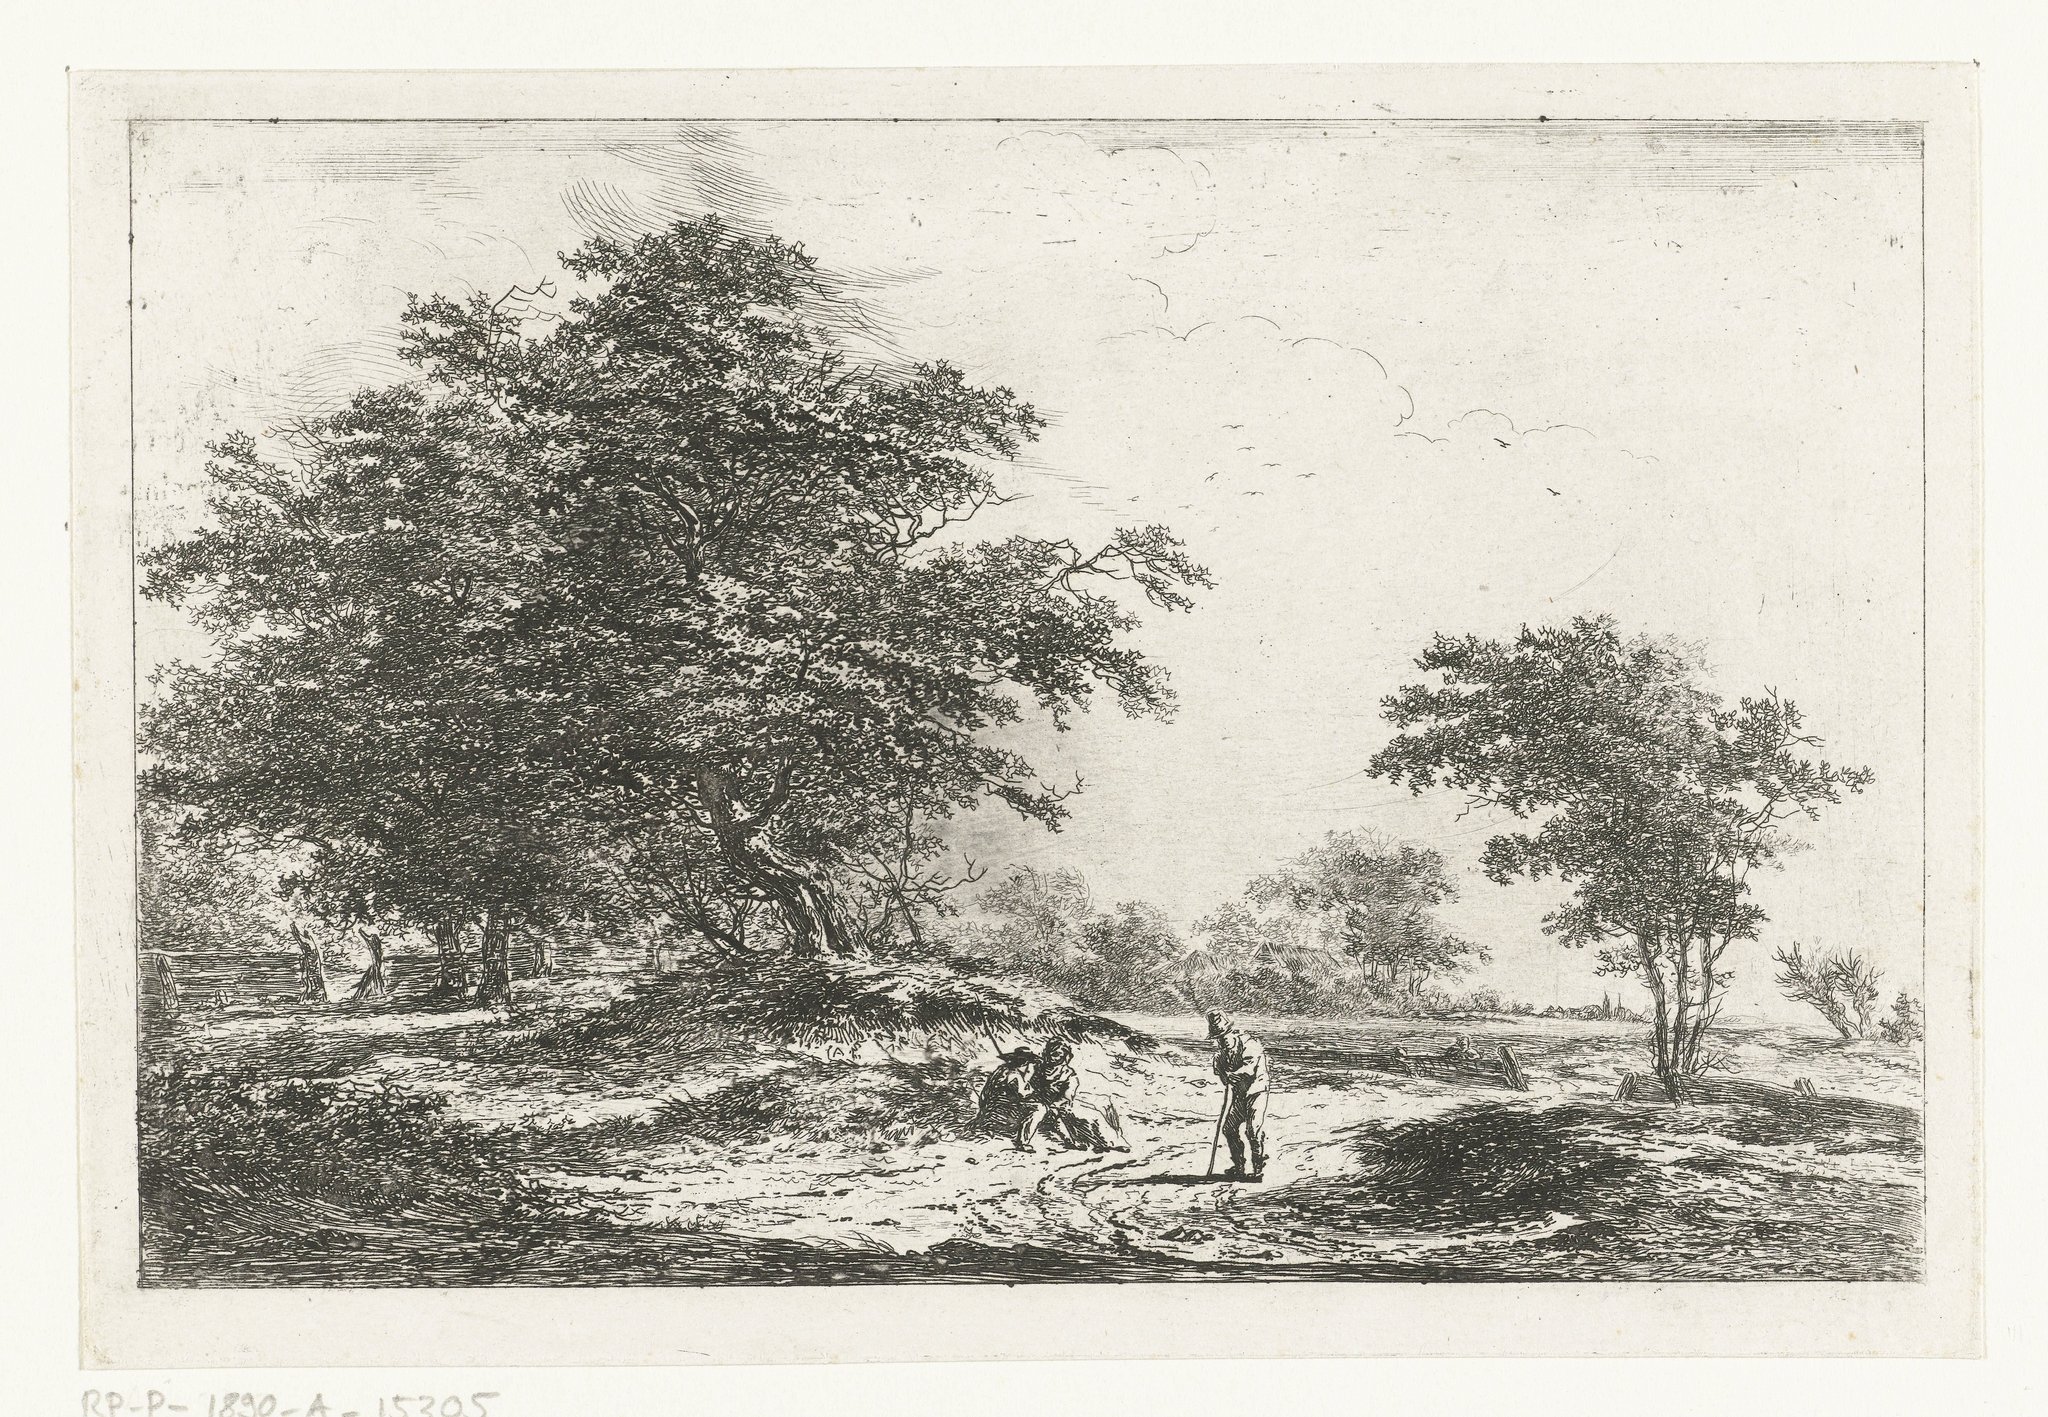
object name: print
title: Landschap met rustende figuren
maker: hermanus van brussel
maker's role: draughtsman, print maker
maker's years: 1763-1815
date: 1800-1815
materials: paper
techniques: etching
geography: netherlands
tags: landscapes in the temperate zone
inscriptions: collector's mark: Lugt 2228